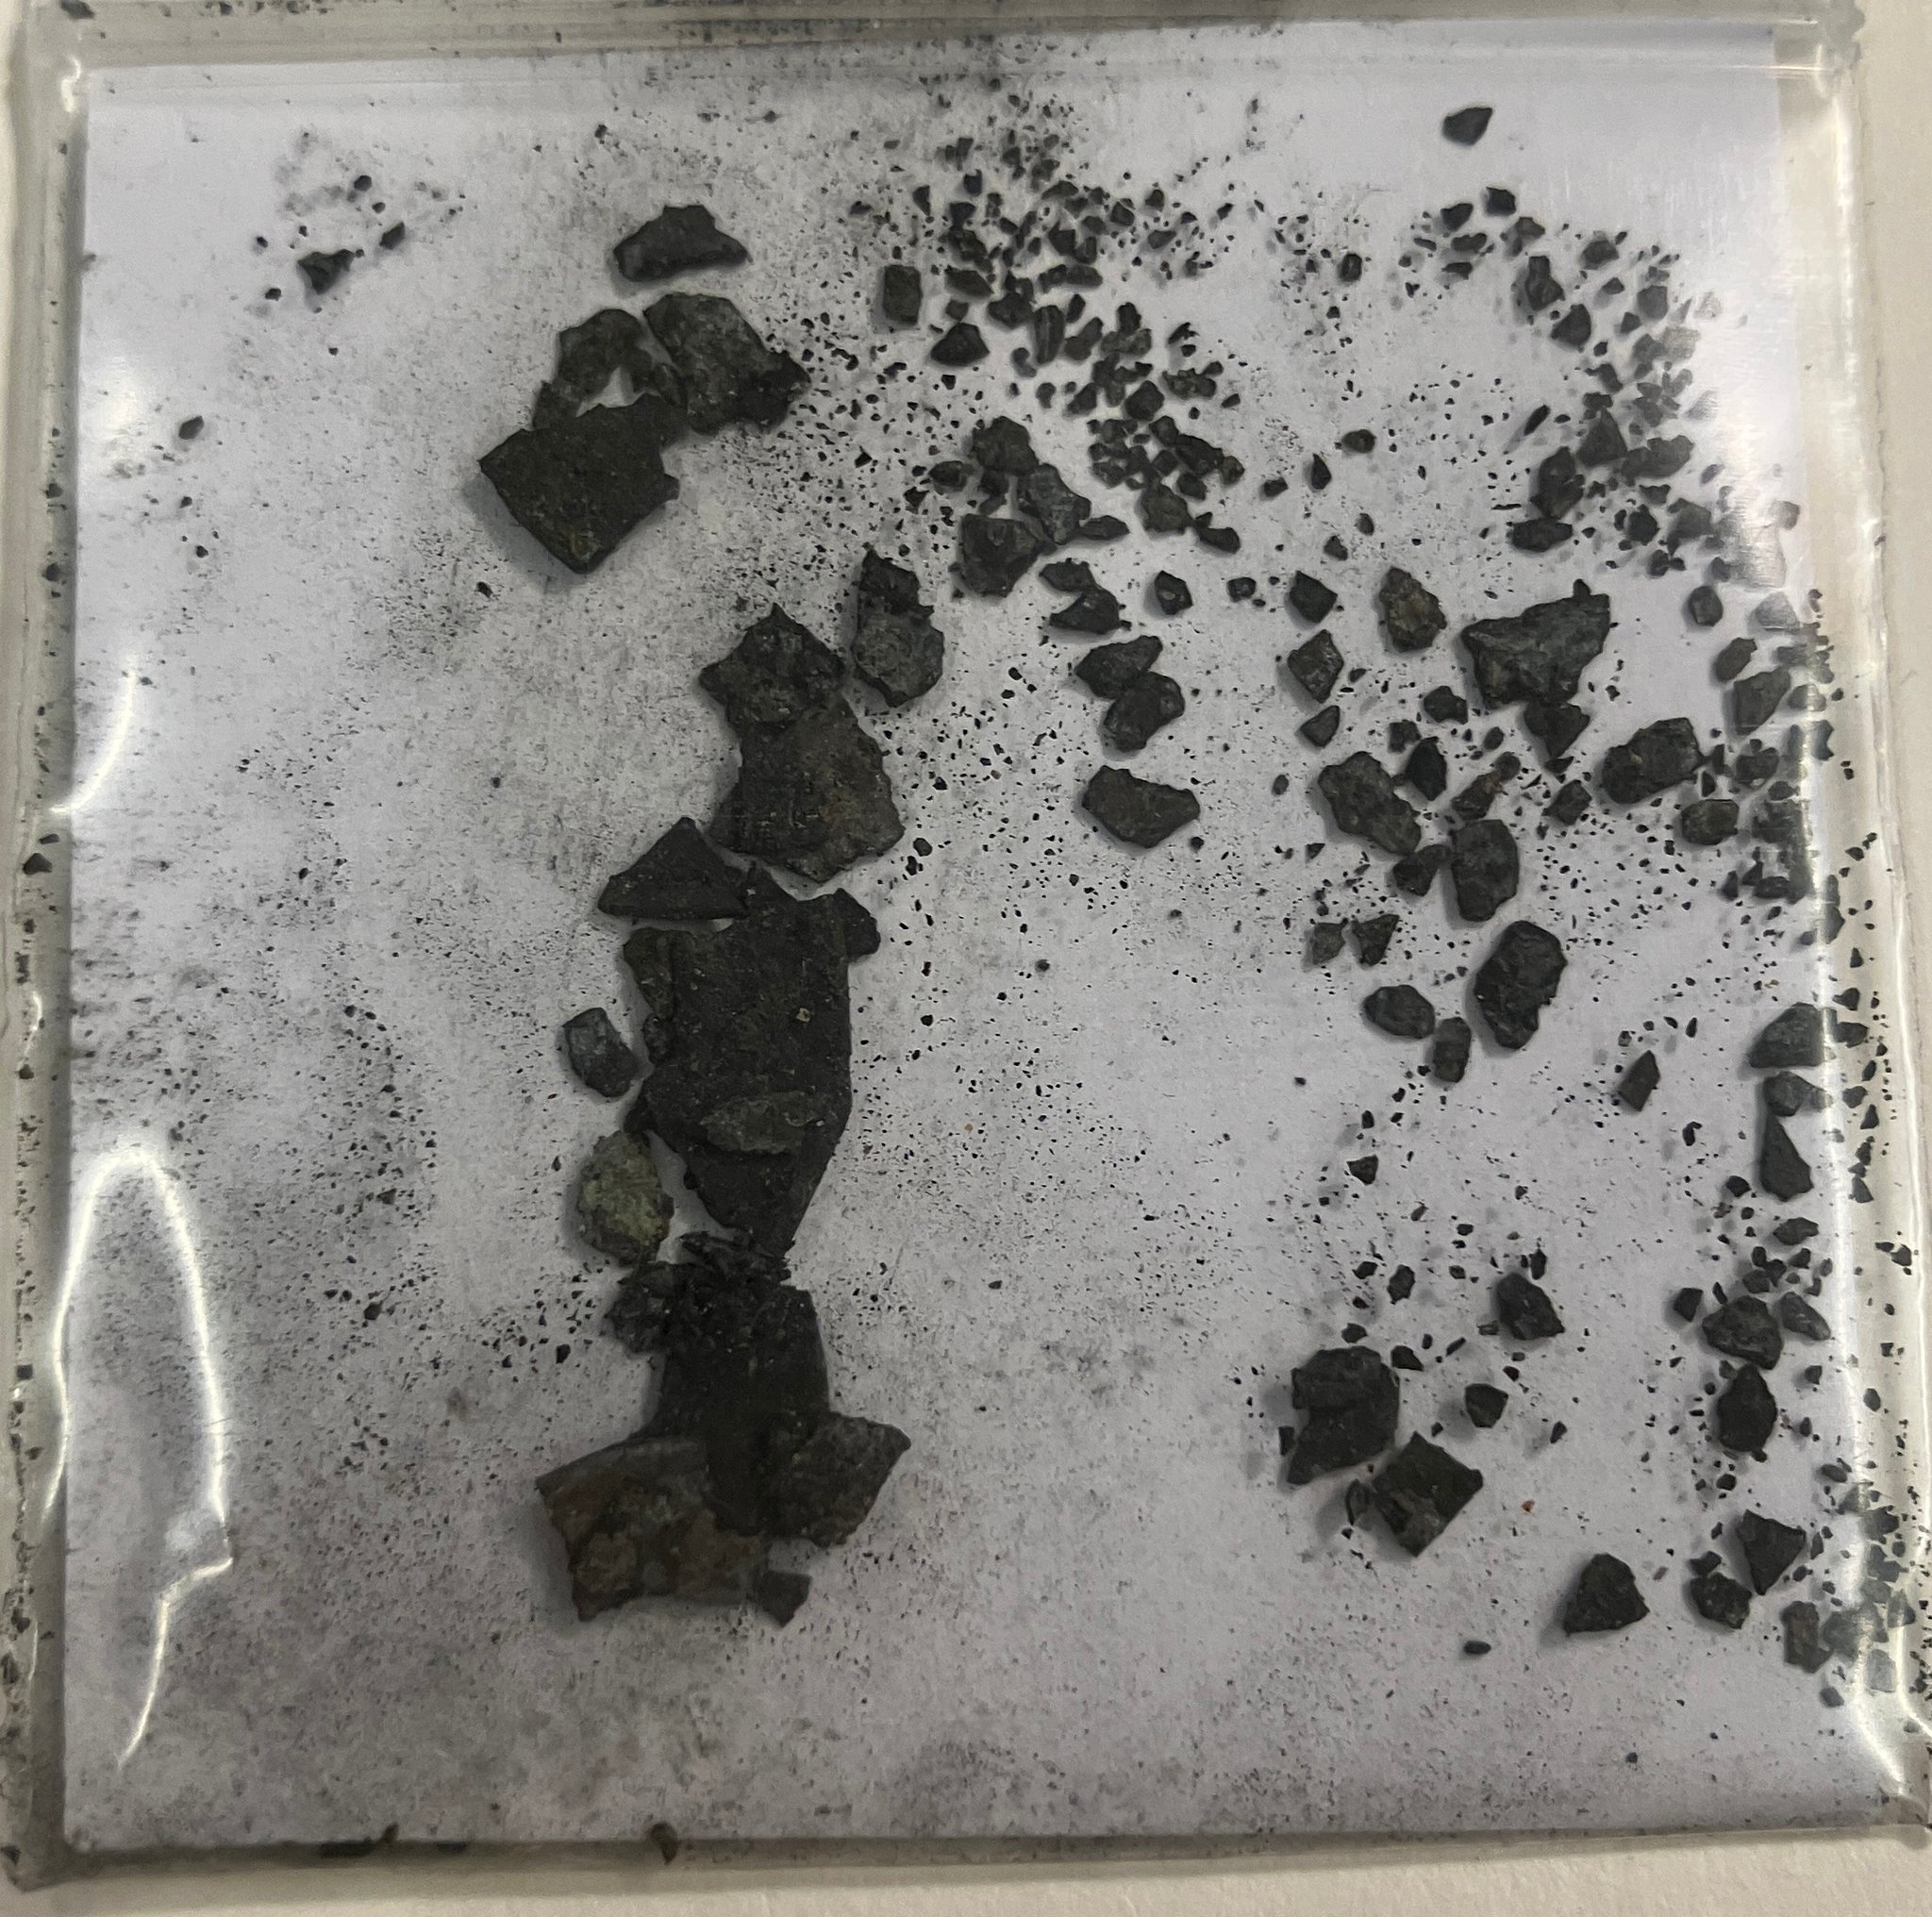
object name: coin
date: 819-1005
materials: silver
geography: iran